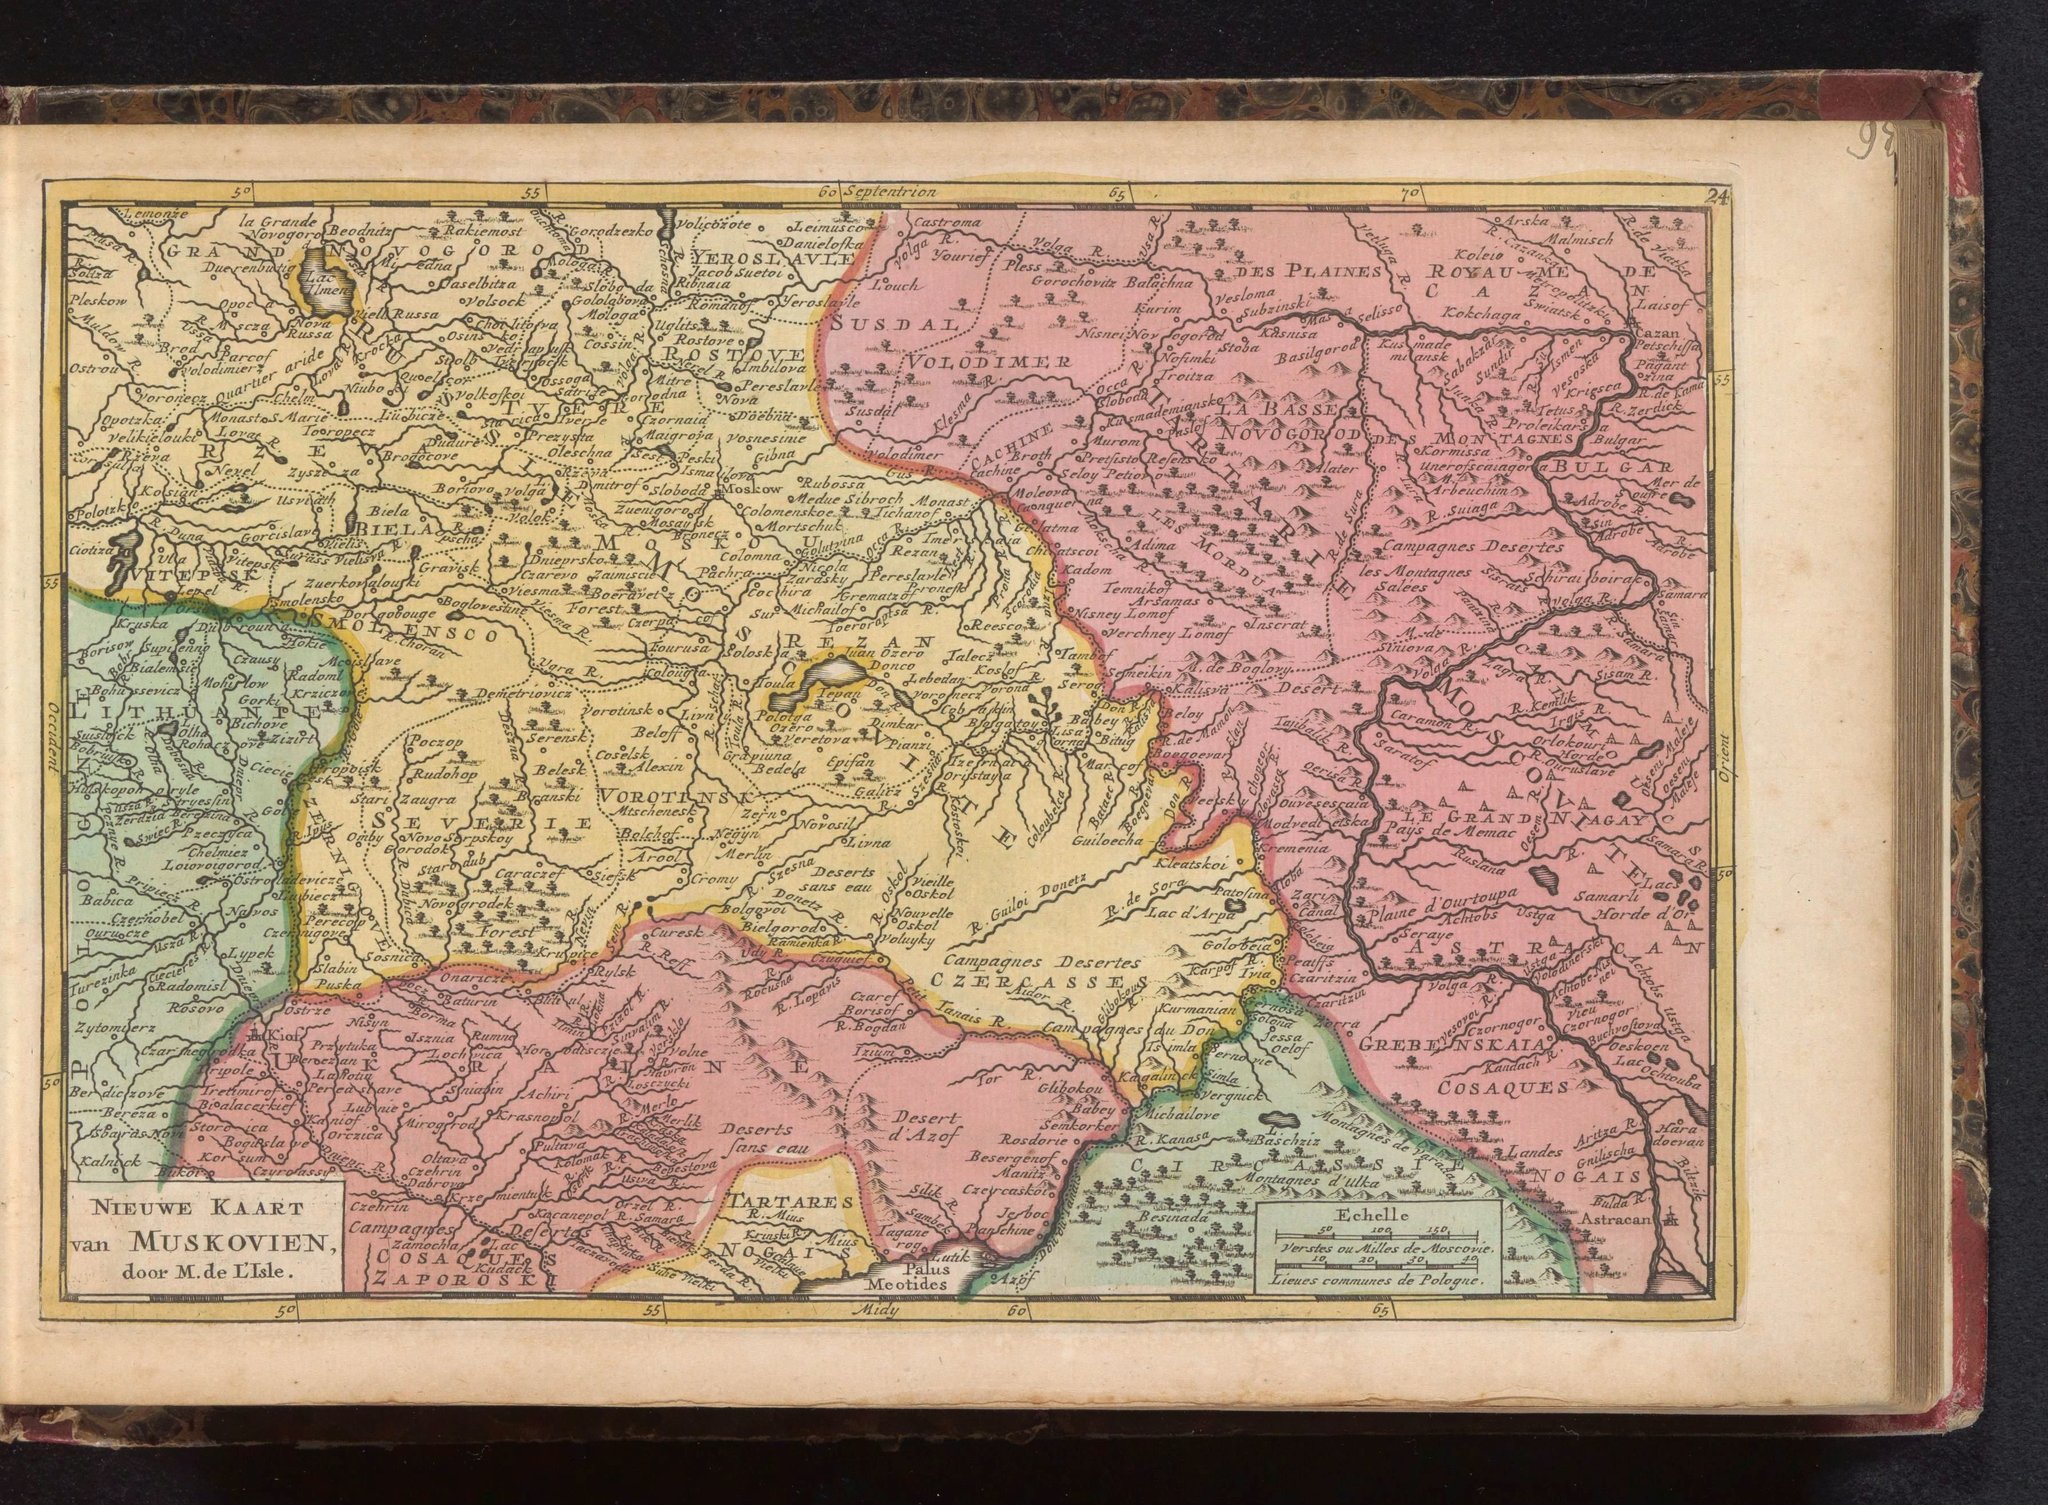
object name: print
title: Kaart van Rusland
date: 1735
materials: paper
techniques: engraving, hand coloring, lacquer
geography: amsterdam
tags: maps of separate countries or regions, russia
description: Kaart van het westelijk deel van Rusland, rechts de rivier de Wolga. Onderdeel van een atlas met 223 kaarten van landen en steden en oorlogstaferelen in Europa in de periode ca. 1690-1735.